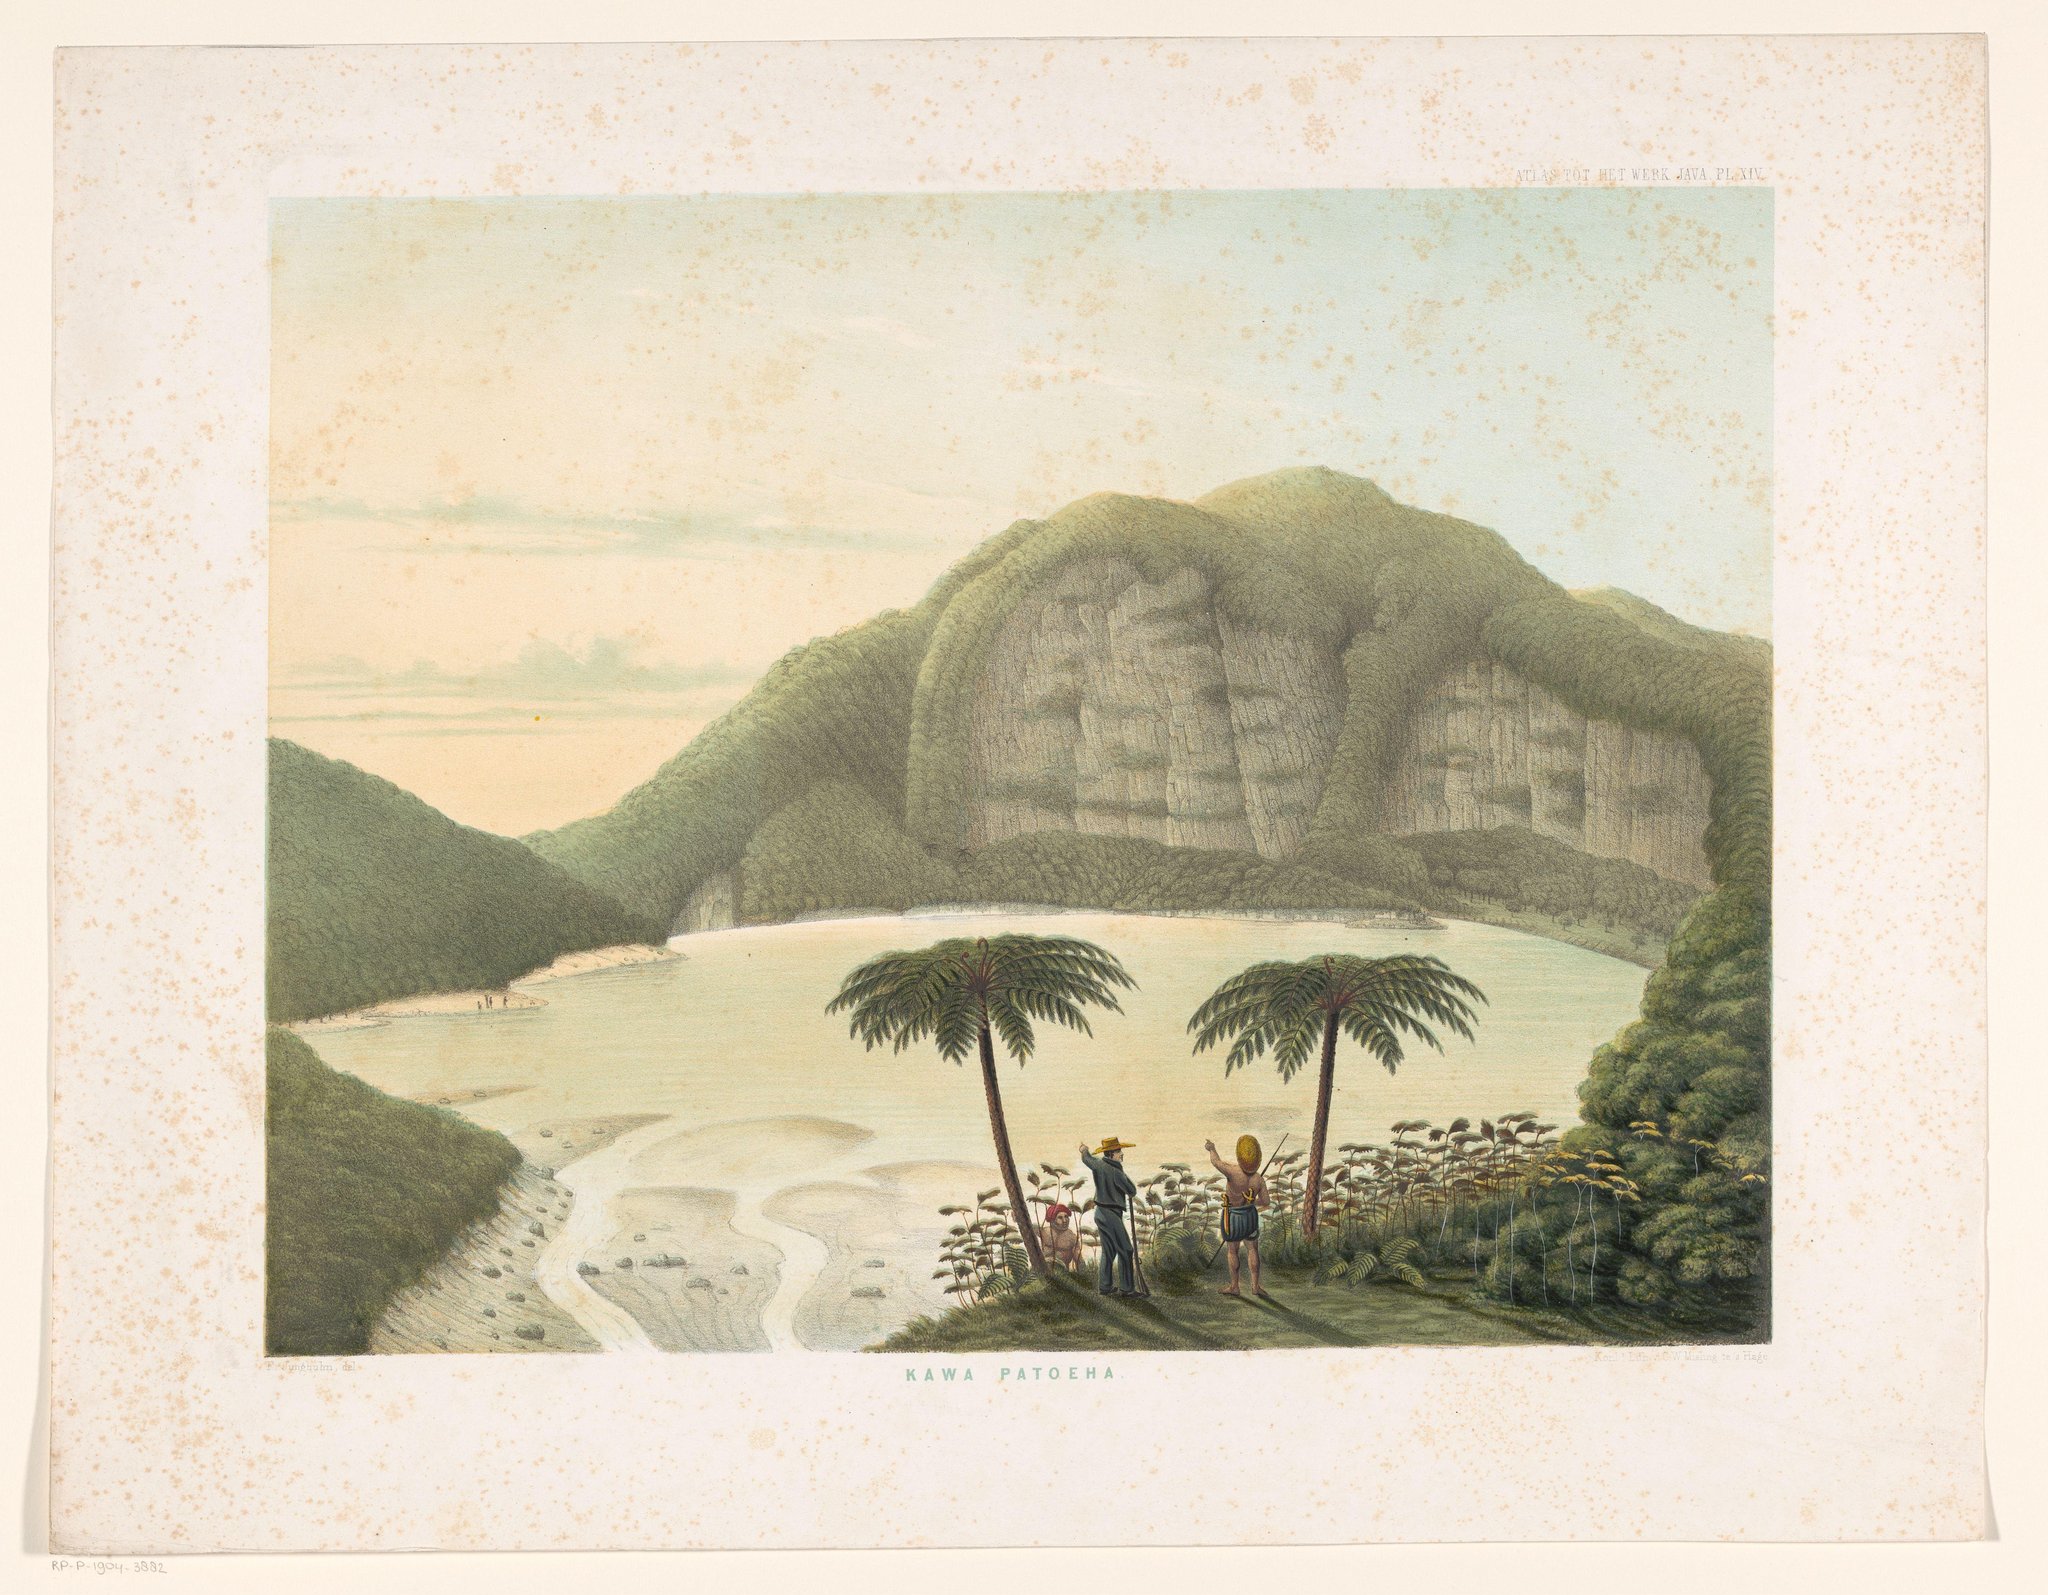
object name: print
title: Atlas van platen bevattende elf pittoreske gezigten, behoorende tot het werk Java, zijne gedaante, zijne plantentooi en inwendige bouw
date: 1854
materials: paper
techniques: lithograph, hand coloring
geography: the hague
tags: lake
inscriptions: collector's mark: Lugt 2228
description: Onderdeel van een serie van elf. Deze serie is uitgebracht als aanvulling op: Junghuhn, F.W. Java, zijne gedaante, zijn plantentooi en inwendige bouw (I, II, III, IV). Den Haag: Mieling, C.W. 1853-54. Zie ook RP-P-1904-3878 (ander kleurenpalet).